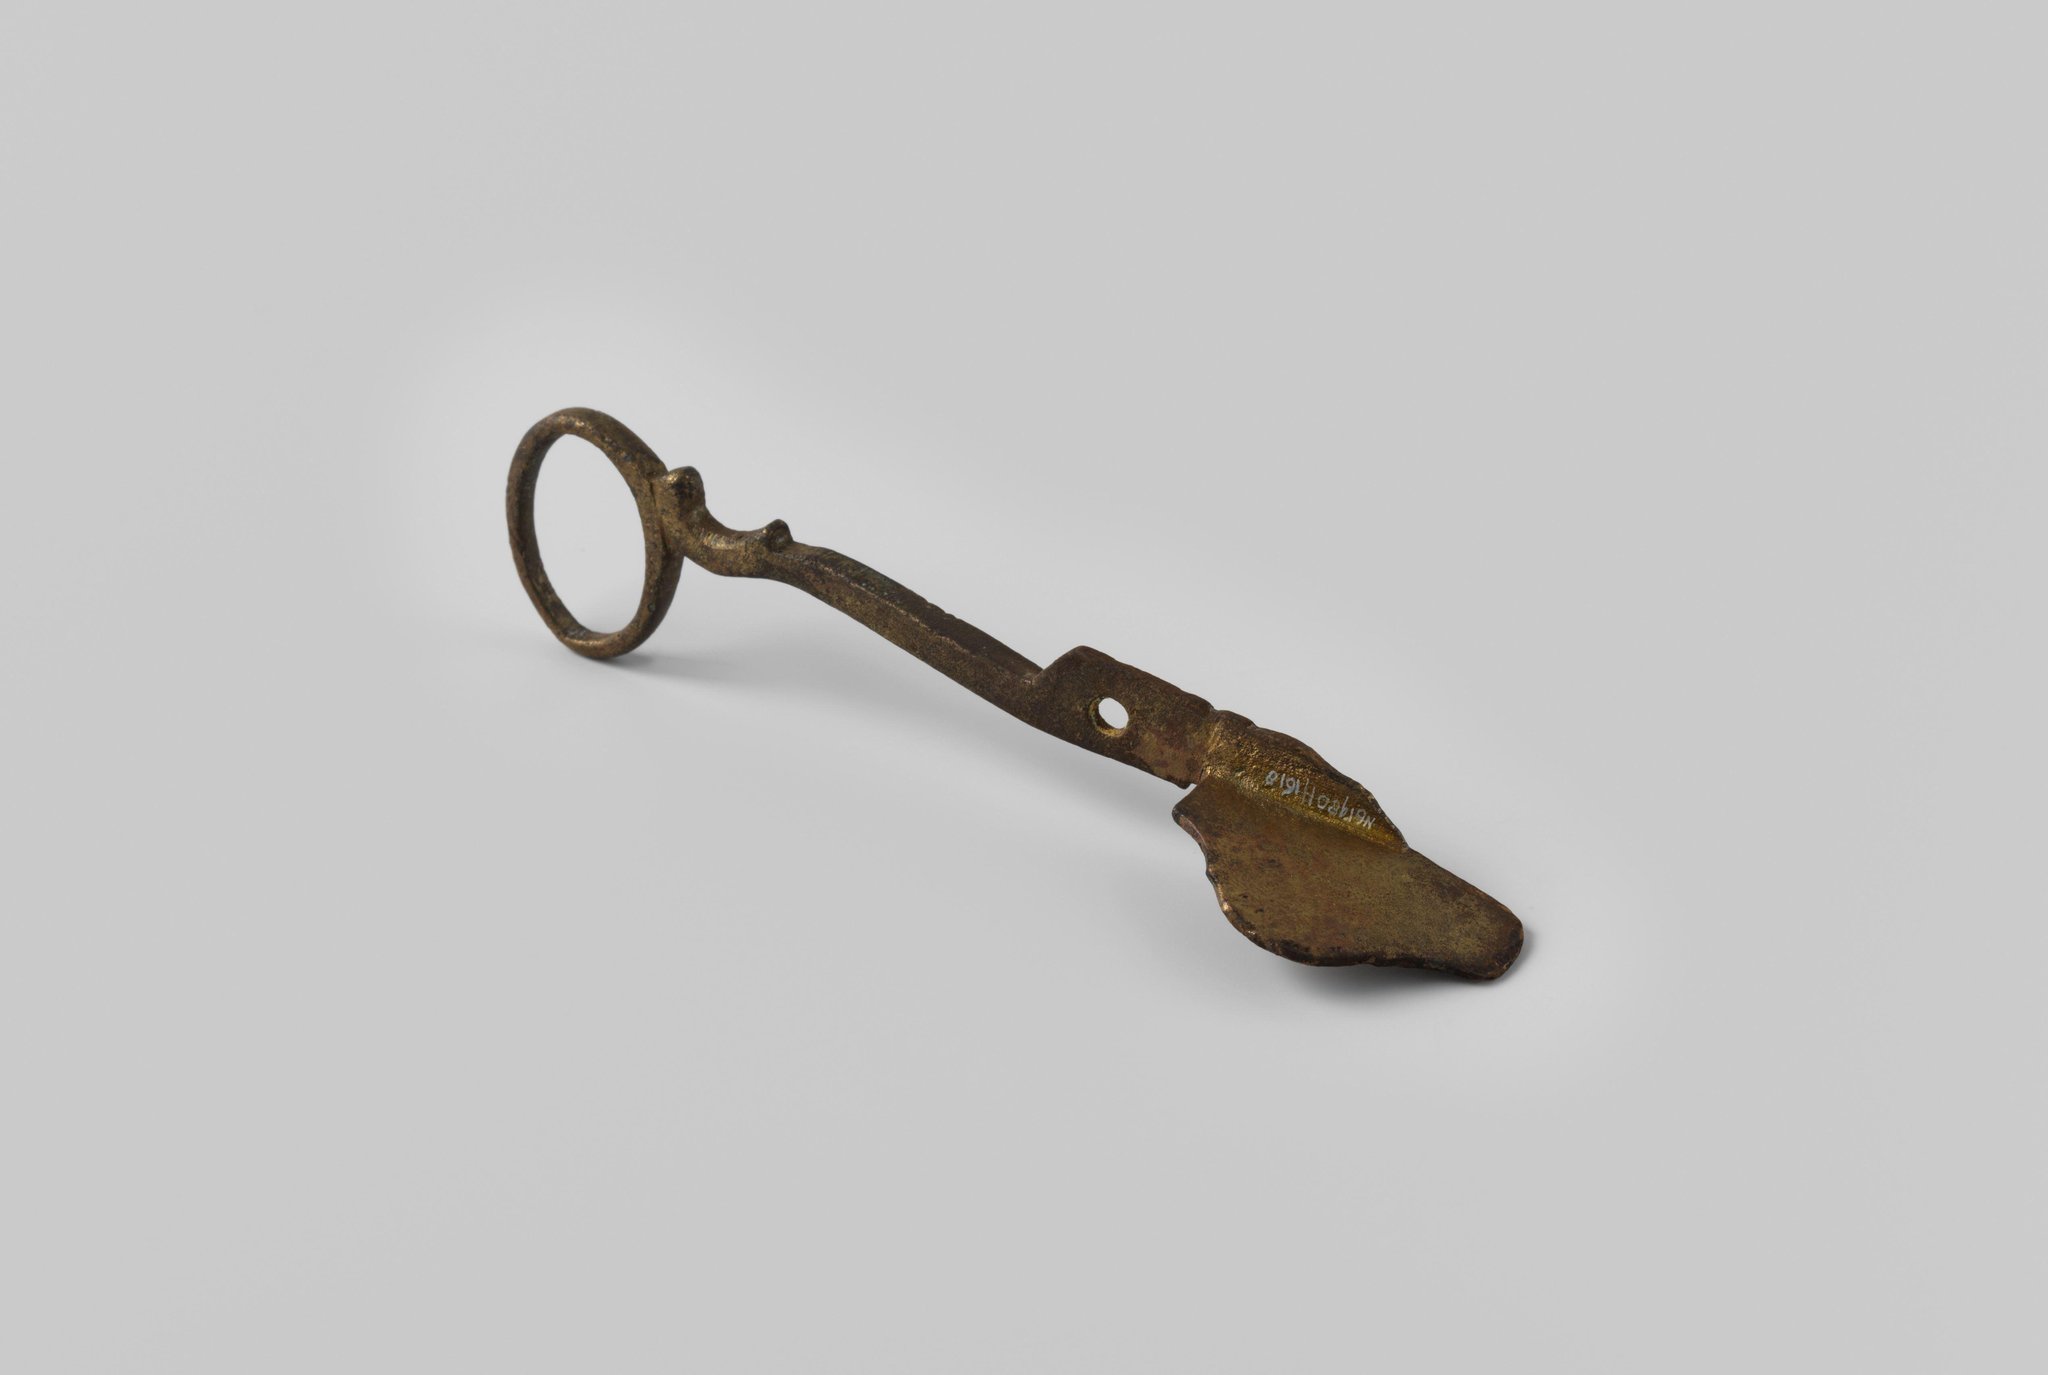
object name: snuiter, snuiterschaar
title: Candle snuffer from the wreck of the Dutch East Indiaman Hollandia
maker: Anonymous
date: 1700-1743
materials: copper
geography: netherlands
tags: verenigde oostindische compagnie, hollandia (schip), annet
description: Snuffer; fragm, leg of scissor: oval bow, shaft square in section, with circular pivot hole, at the end of shaft vertical side of curved snuffer box, plain with inscription (X).